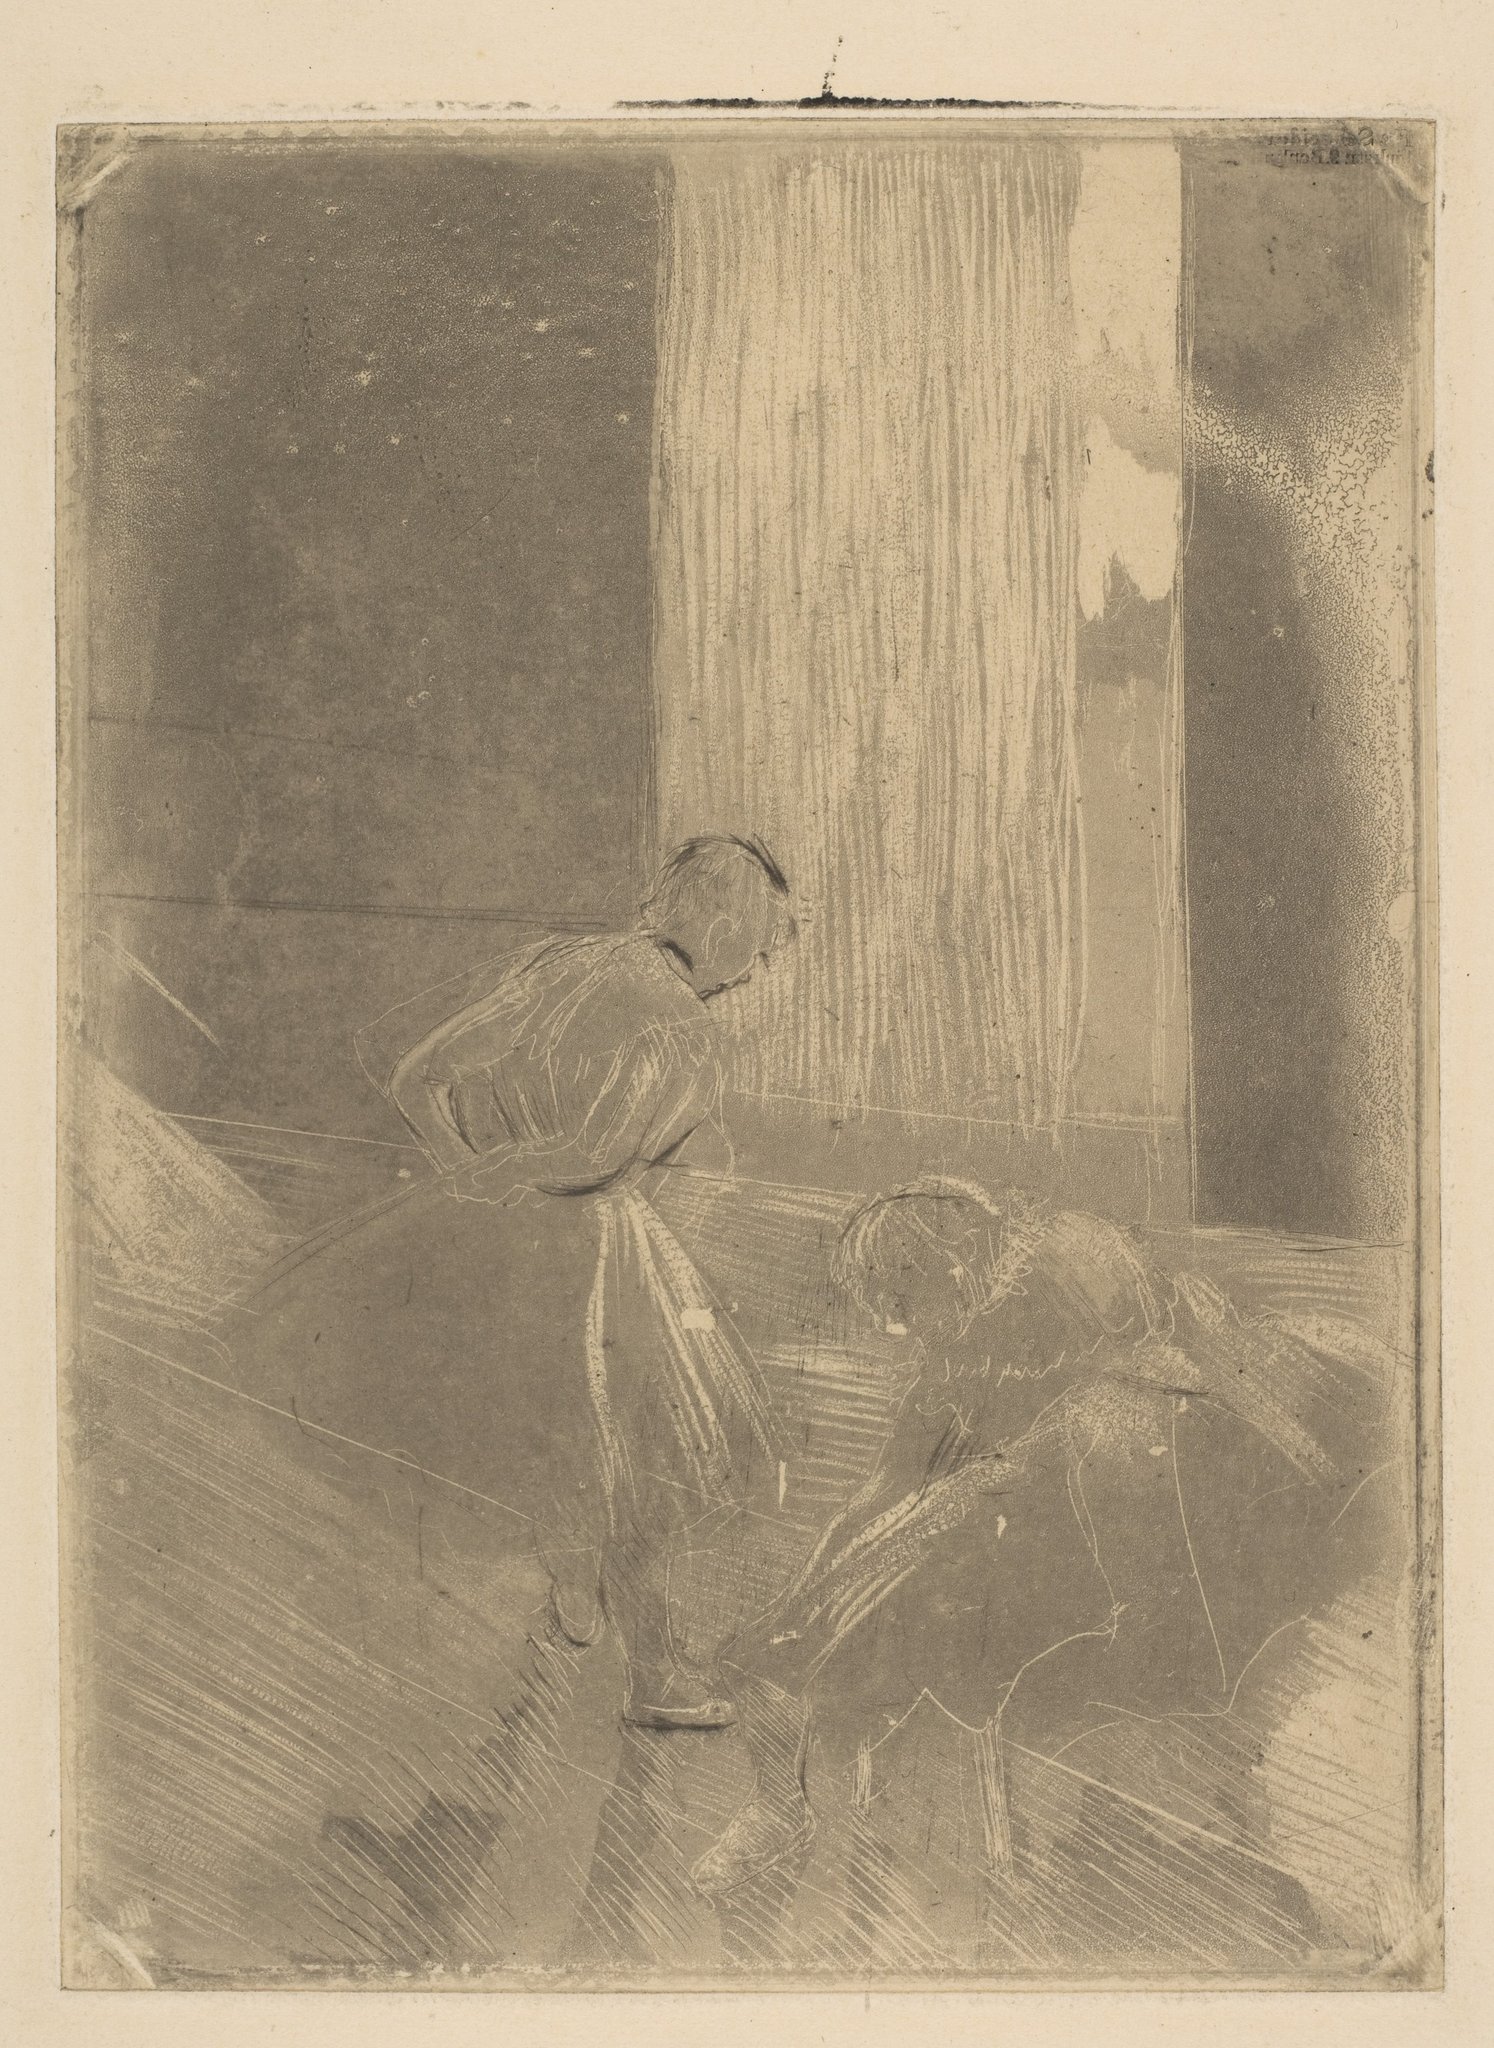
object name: print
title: Two Dancers in a Rehearsal Room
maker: edgar degas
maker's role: artist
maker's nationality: french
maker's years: 1834-1917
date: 1877-1878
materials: paper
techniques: aquatint, drypoint, scraping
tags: women,dancers,ballet